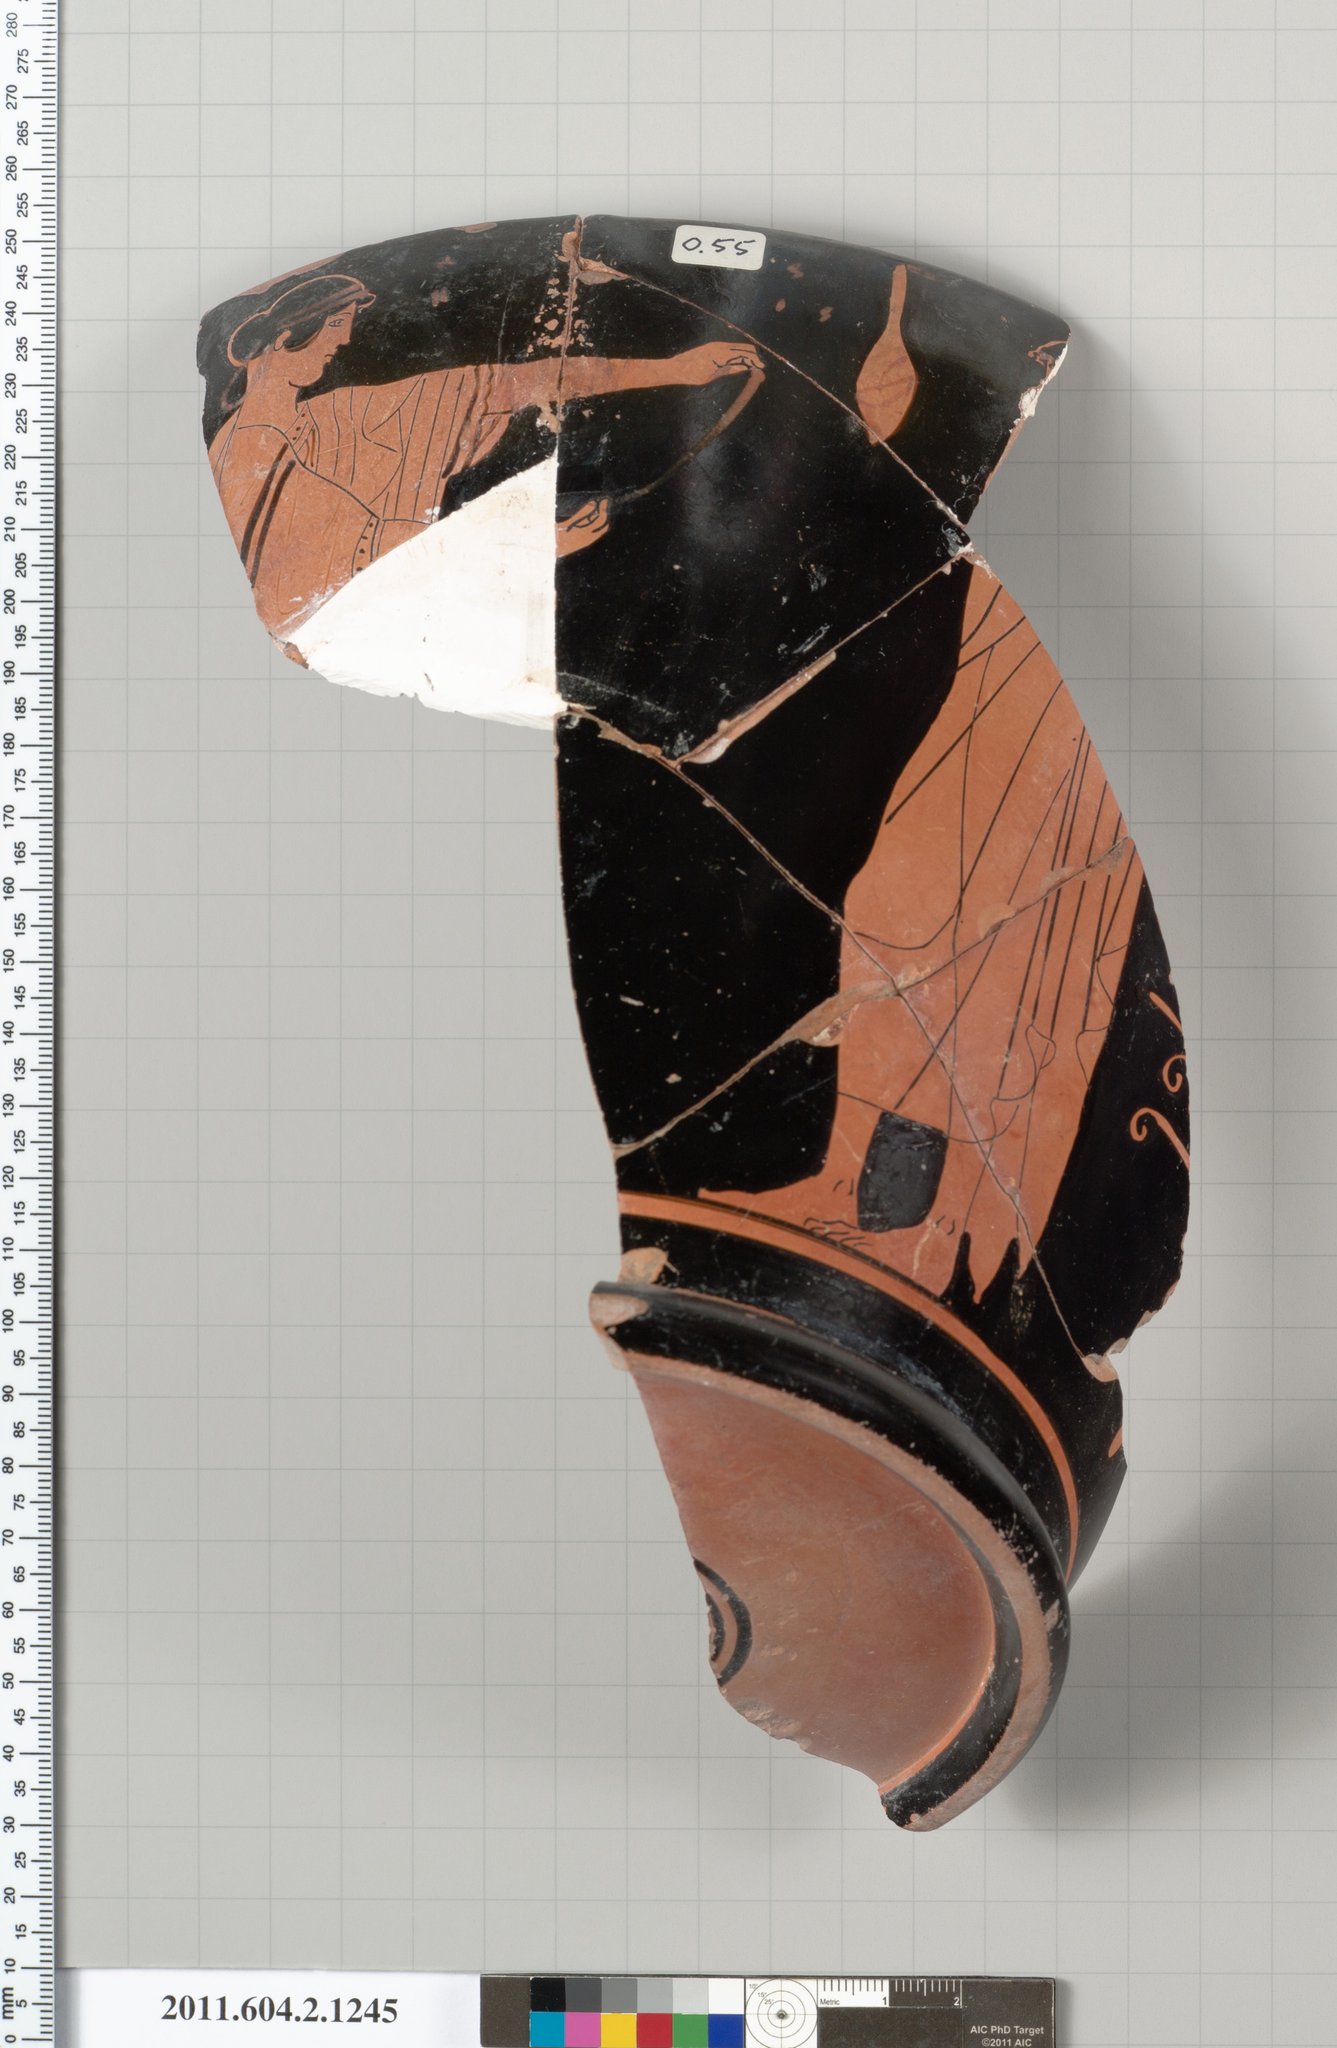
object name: skyphos fragment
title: Terracotta fragment of a skyphos (deep drinking cup)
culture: greek, attic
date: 460-450 BCE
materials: terracotta